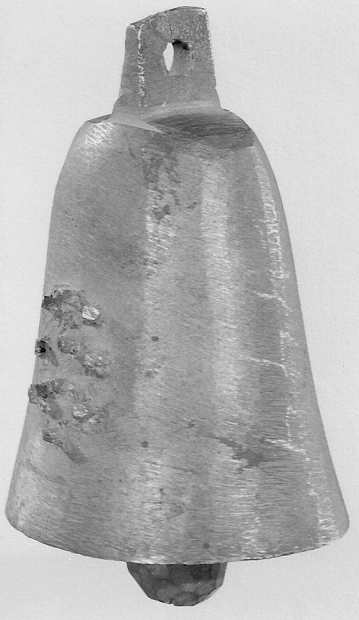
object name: zanguleh zangula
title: Zanguleh (zangula)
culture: iranian or persian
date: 1850-1889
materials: metal, wood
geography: iran